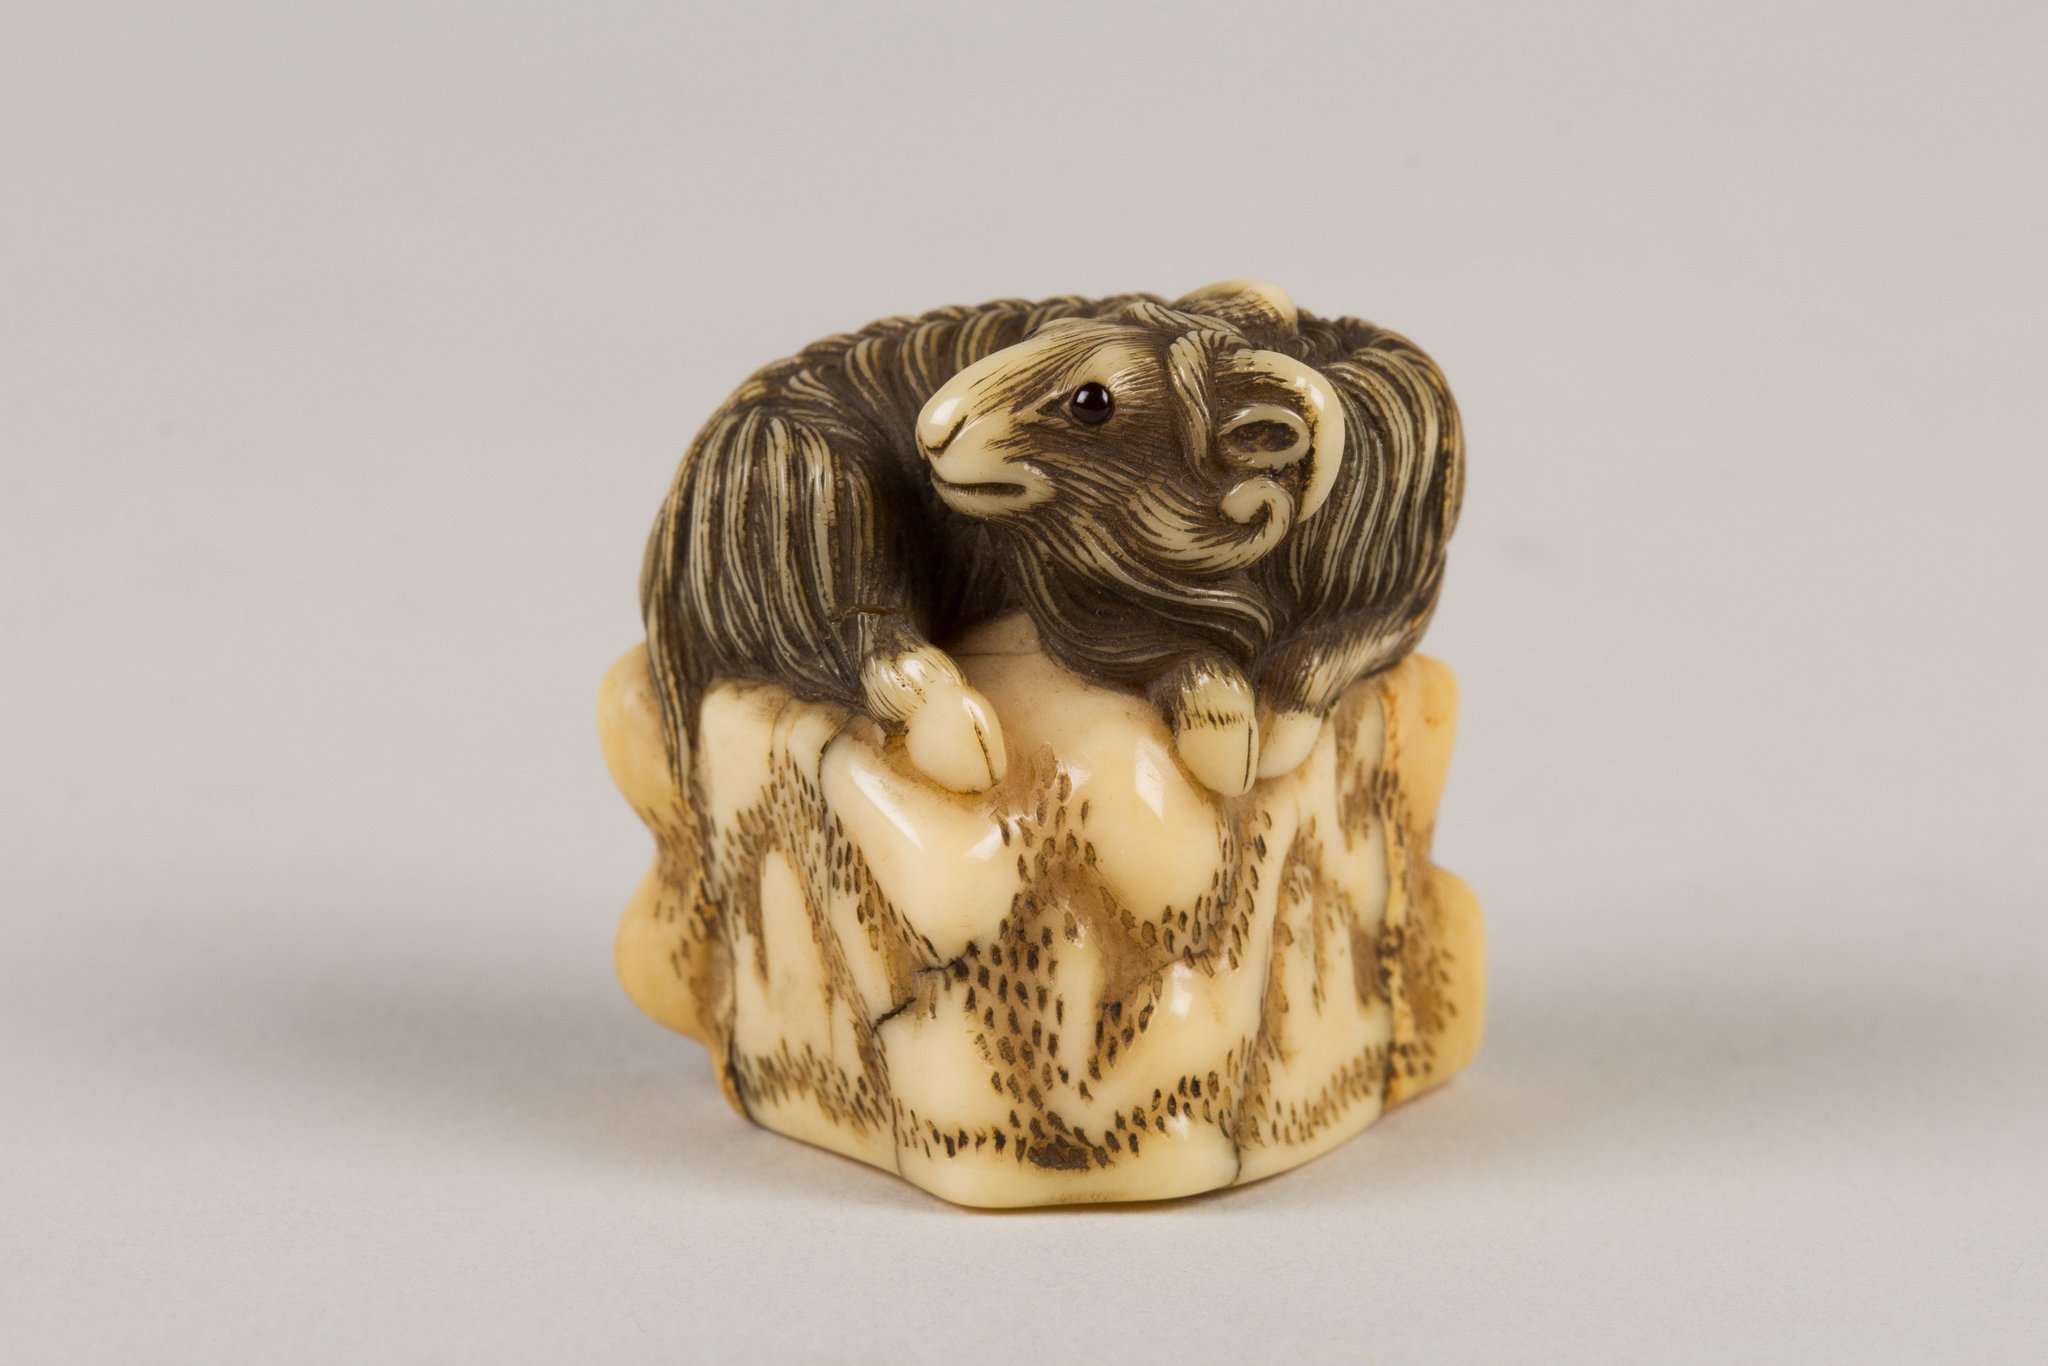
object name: netsuke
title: Netsuke of Goat on a Rock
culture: japanese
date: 1801-1900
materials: ivory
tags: goats